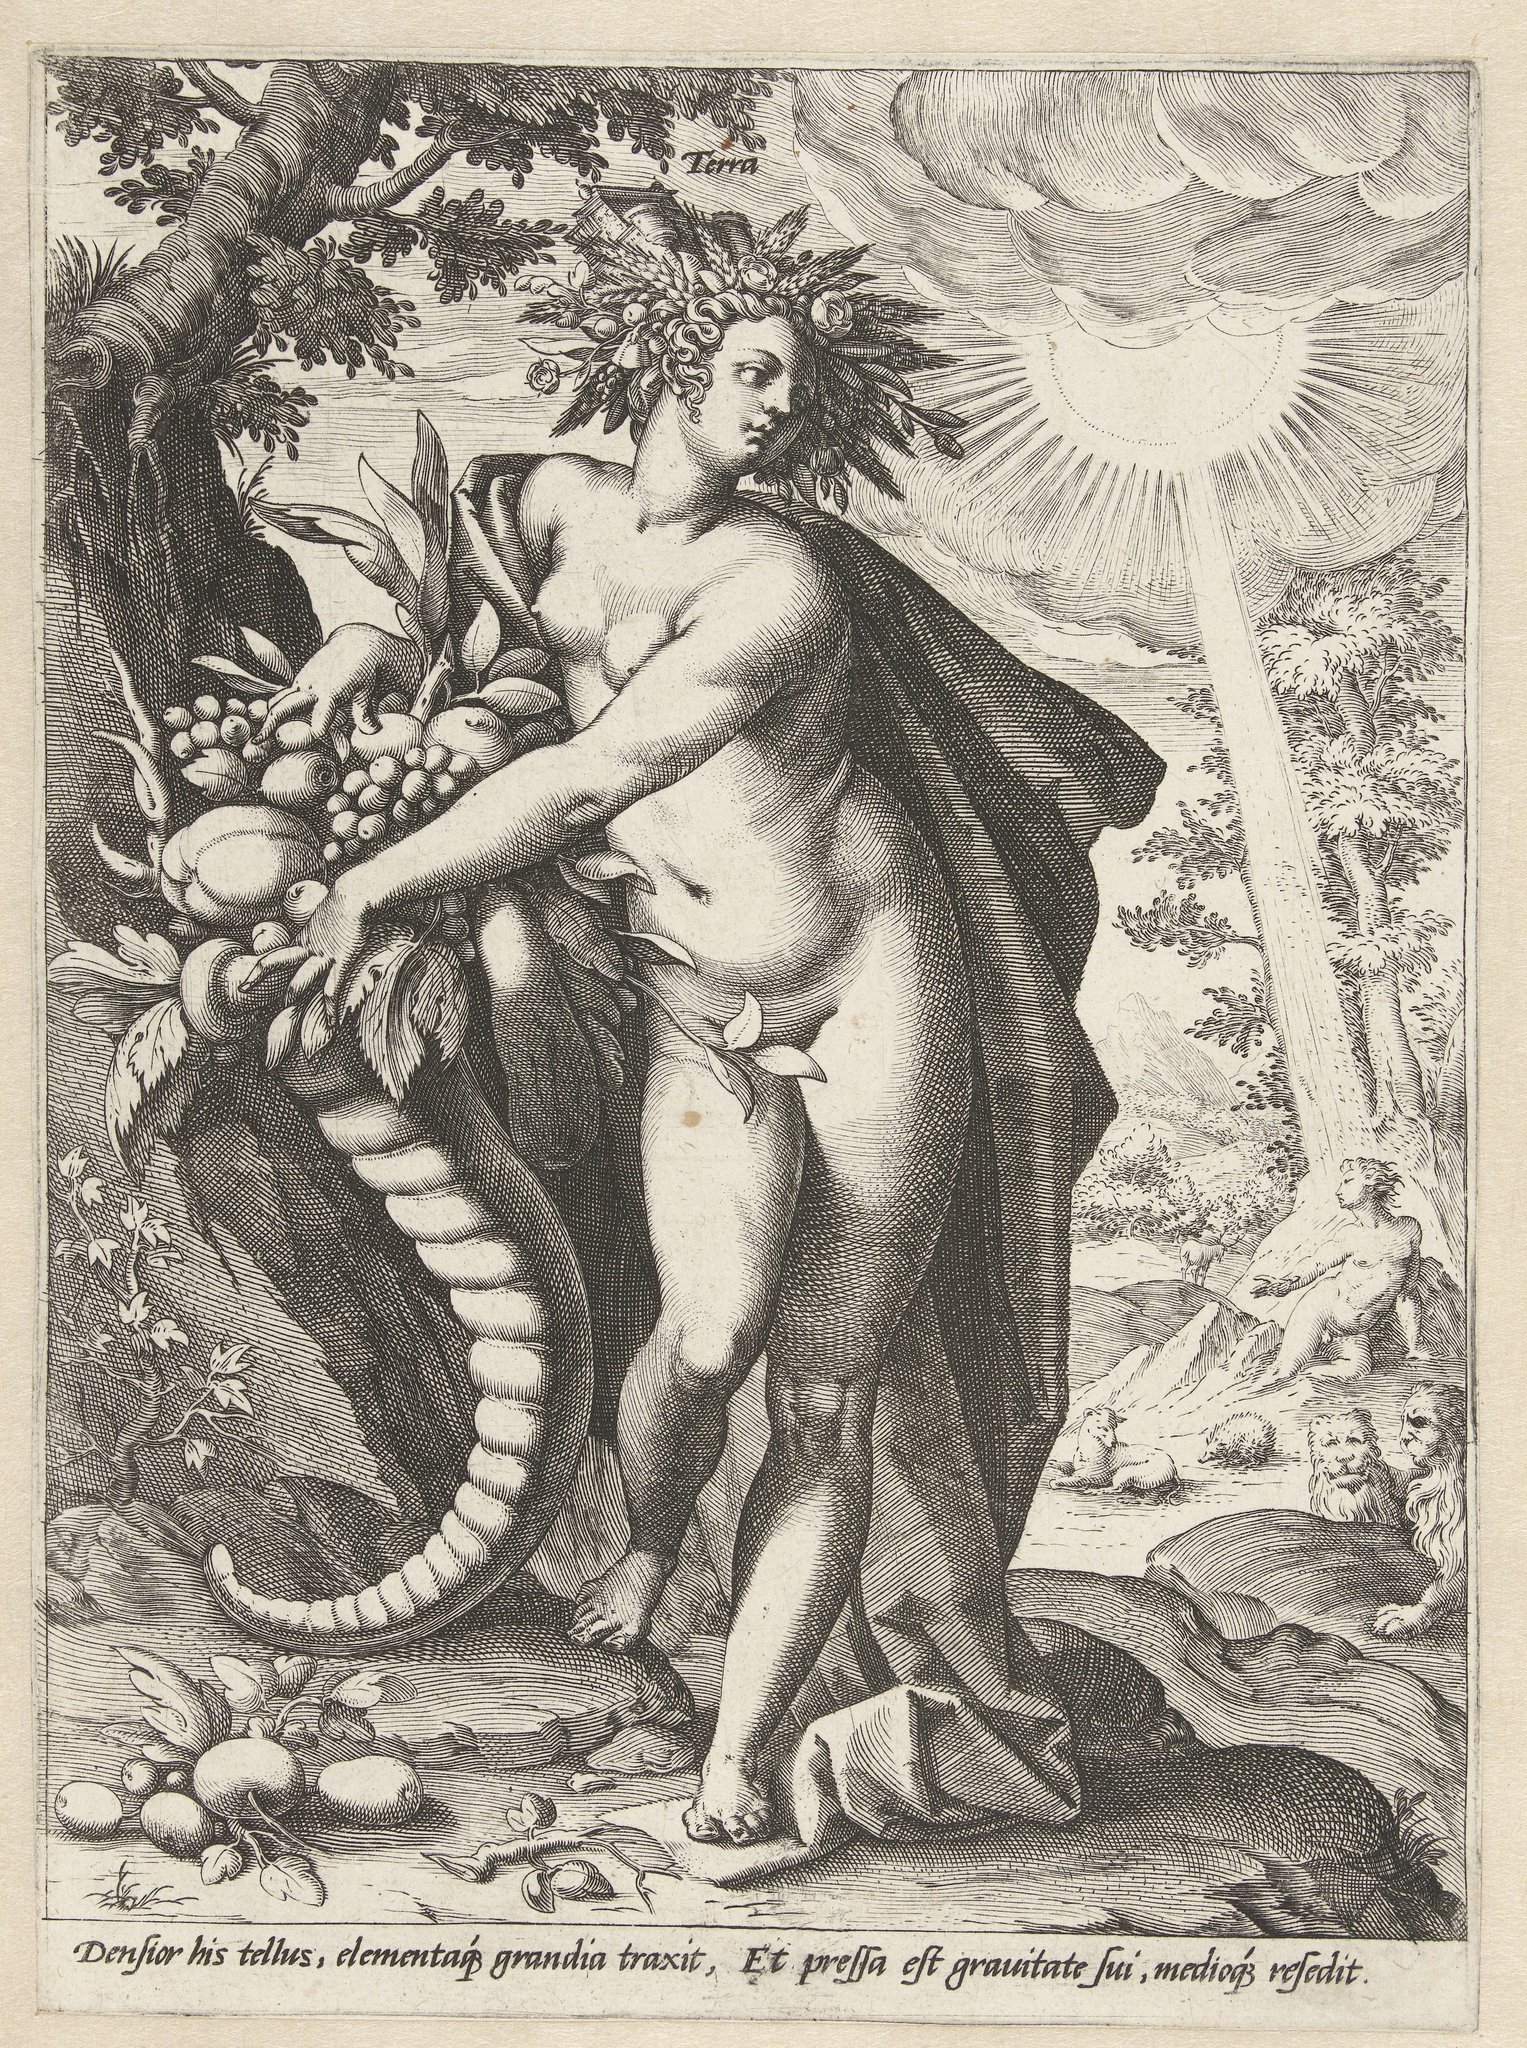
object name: print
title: De vier elementen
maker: hendrick goltzius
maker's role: draughtsman, painter, print maker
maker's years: 1558-1617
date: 1586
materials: paper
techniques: engraving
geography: haarlem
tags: earth (one of the four elements)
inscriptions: collector's mark: Lugt 240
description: Vrouw, staande in een landschap, een hoorn des overvloeds in de handen. Op de achtergrond een man temidden van een aantal dieren. Onder de voorstelling twee regels Latijn. Deze prent is onderdeel van een serie van de vier elementen.